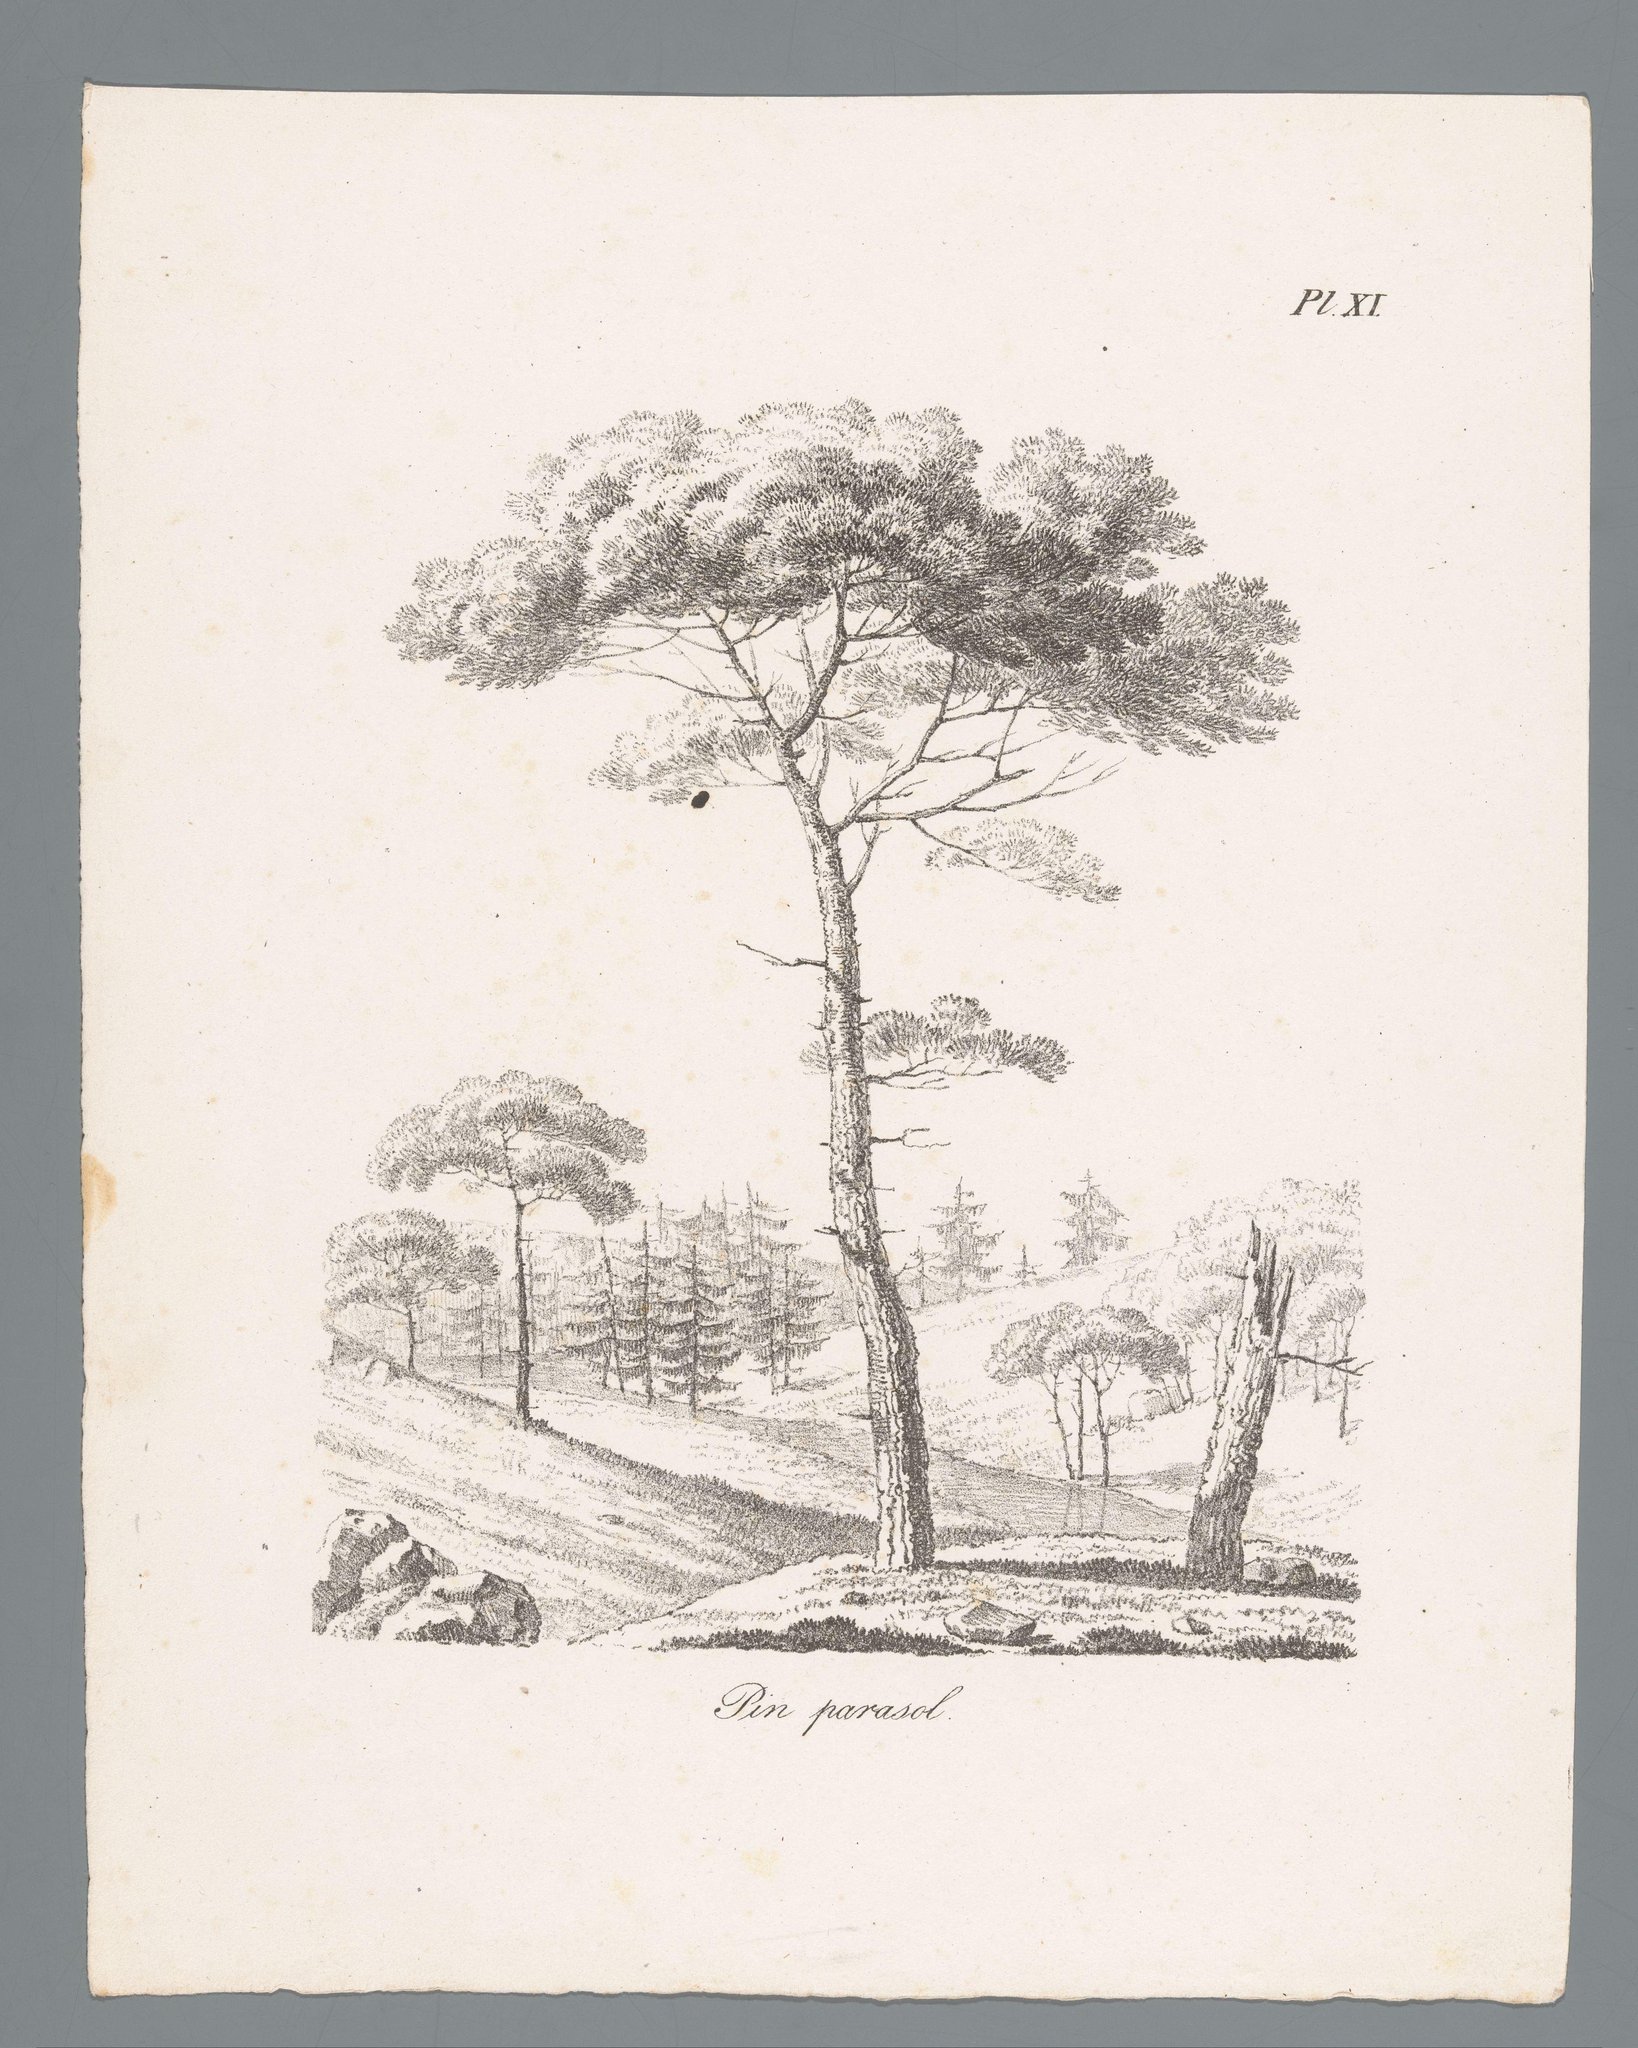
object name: print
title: Parasolden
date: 1820-1833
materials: paper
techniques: lithograph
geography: paris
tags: trees: pine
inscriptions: collector's mark: Lugt 2228